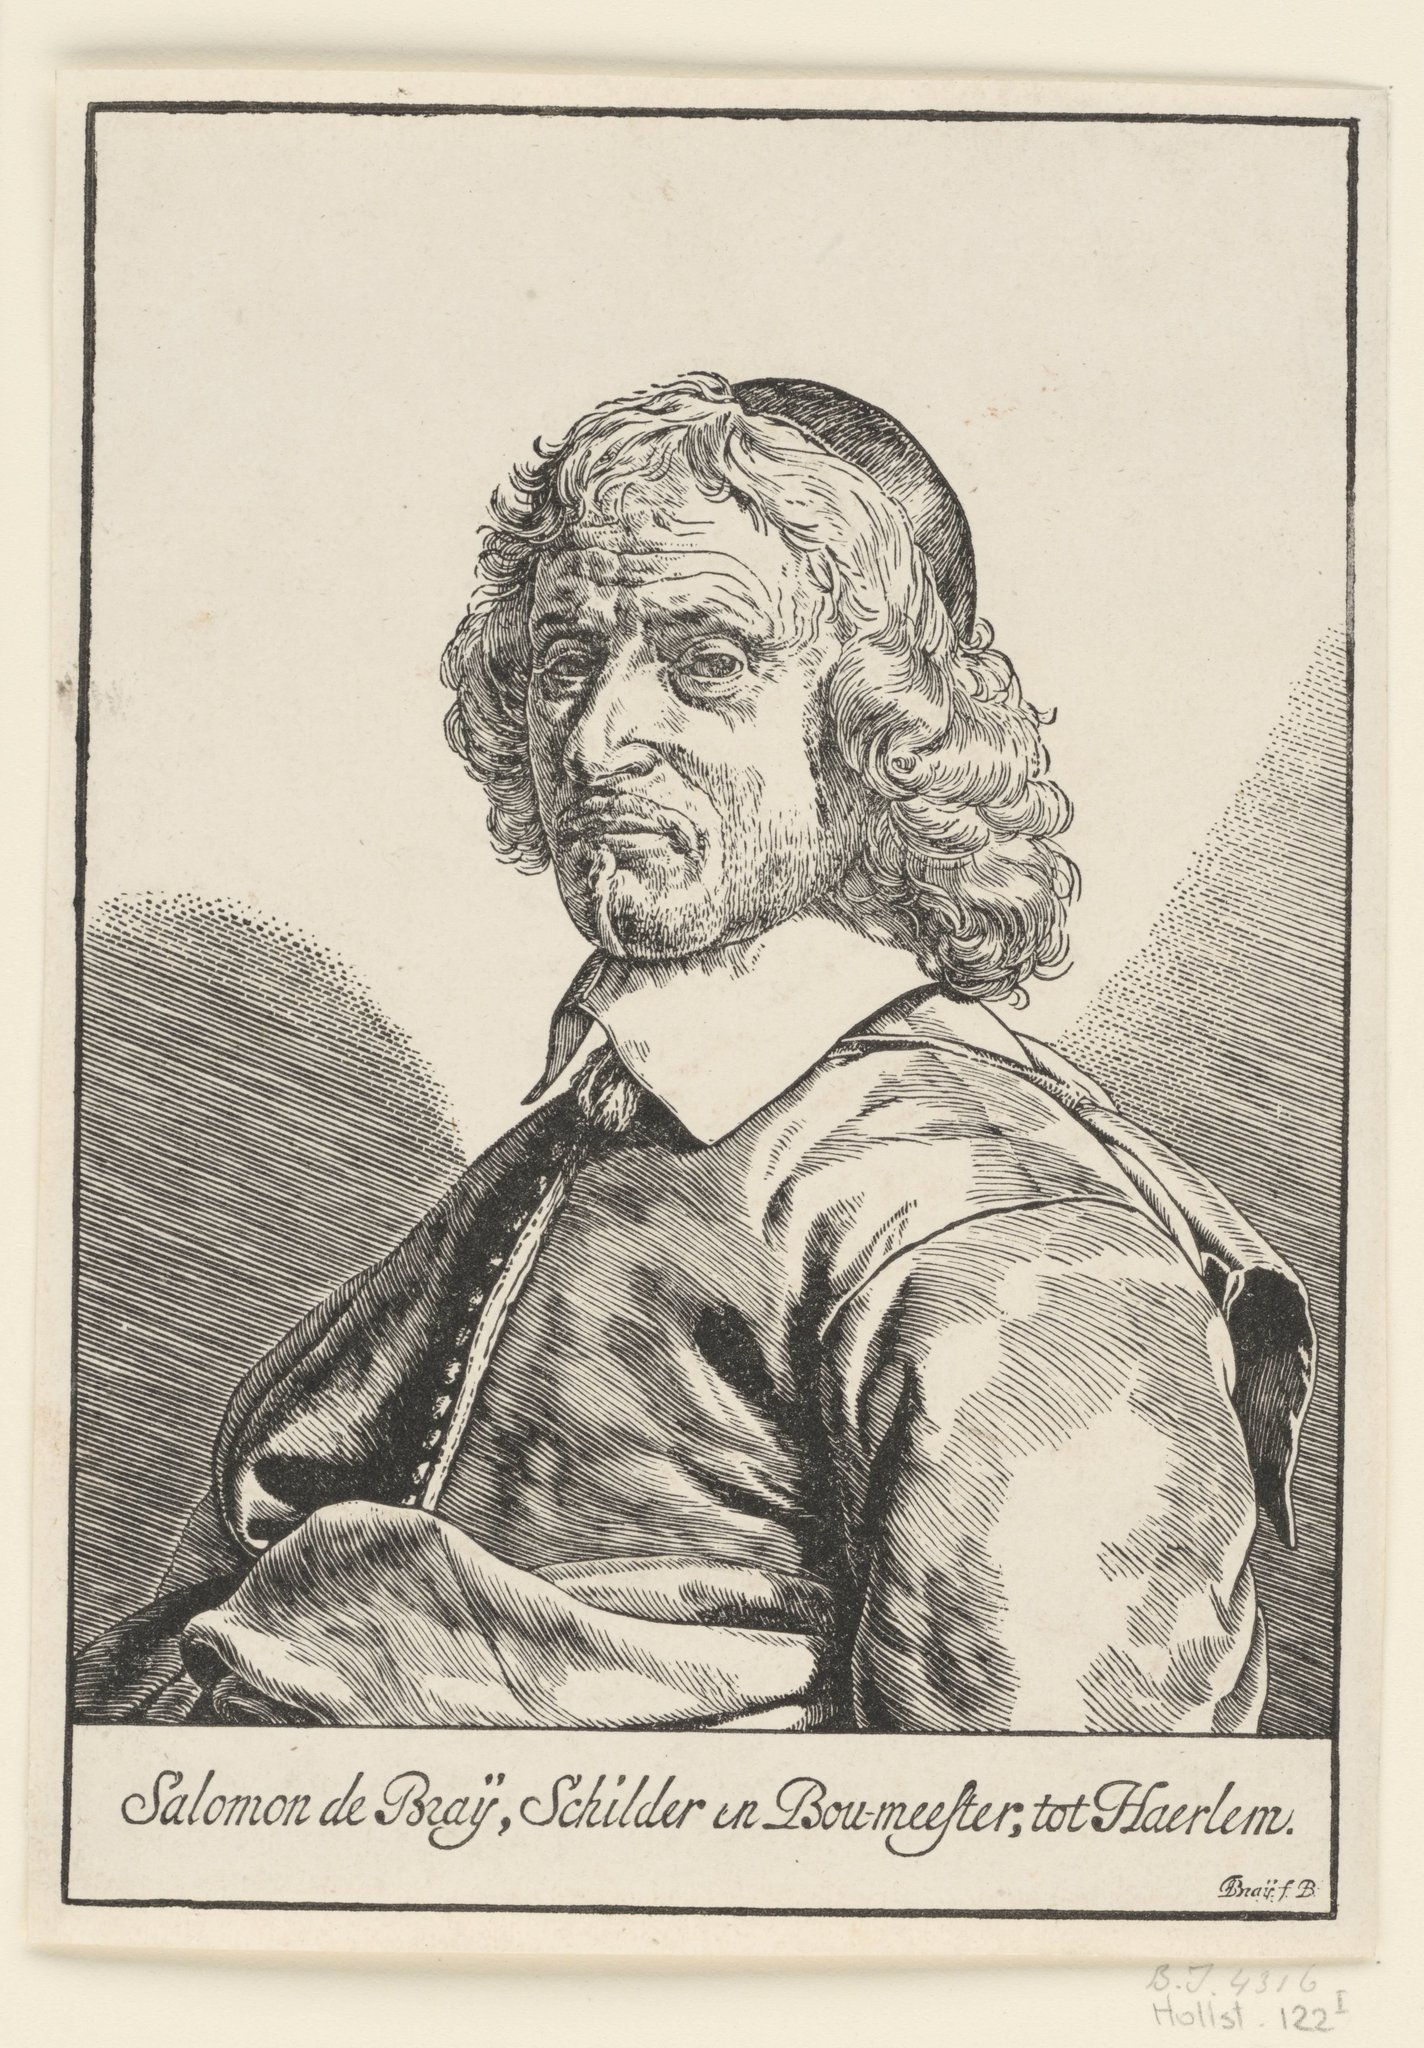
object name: print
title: Portret van Salomon de Bray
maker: dirck de bray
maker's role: draughtsman, painter, print maker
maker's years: 1625-1694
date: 1664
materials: paper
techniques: woodcut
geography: netherlands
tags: amsterdam, salomon de bray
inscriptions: collector's mark: Lugt 240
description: Portret van Salomon de Bray. In een kader zijn naam en beroep.